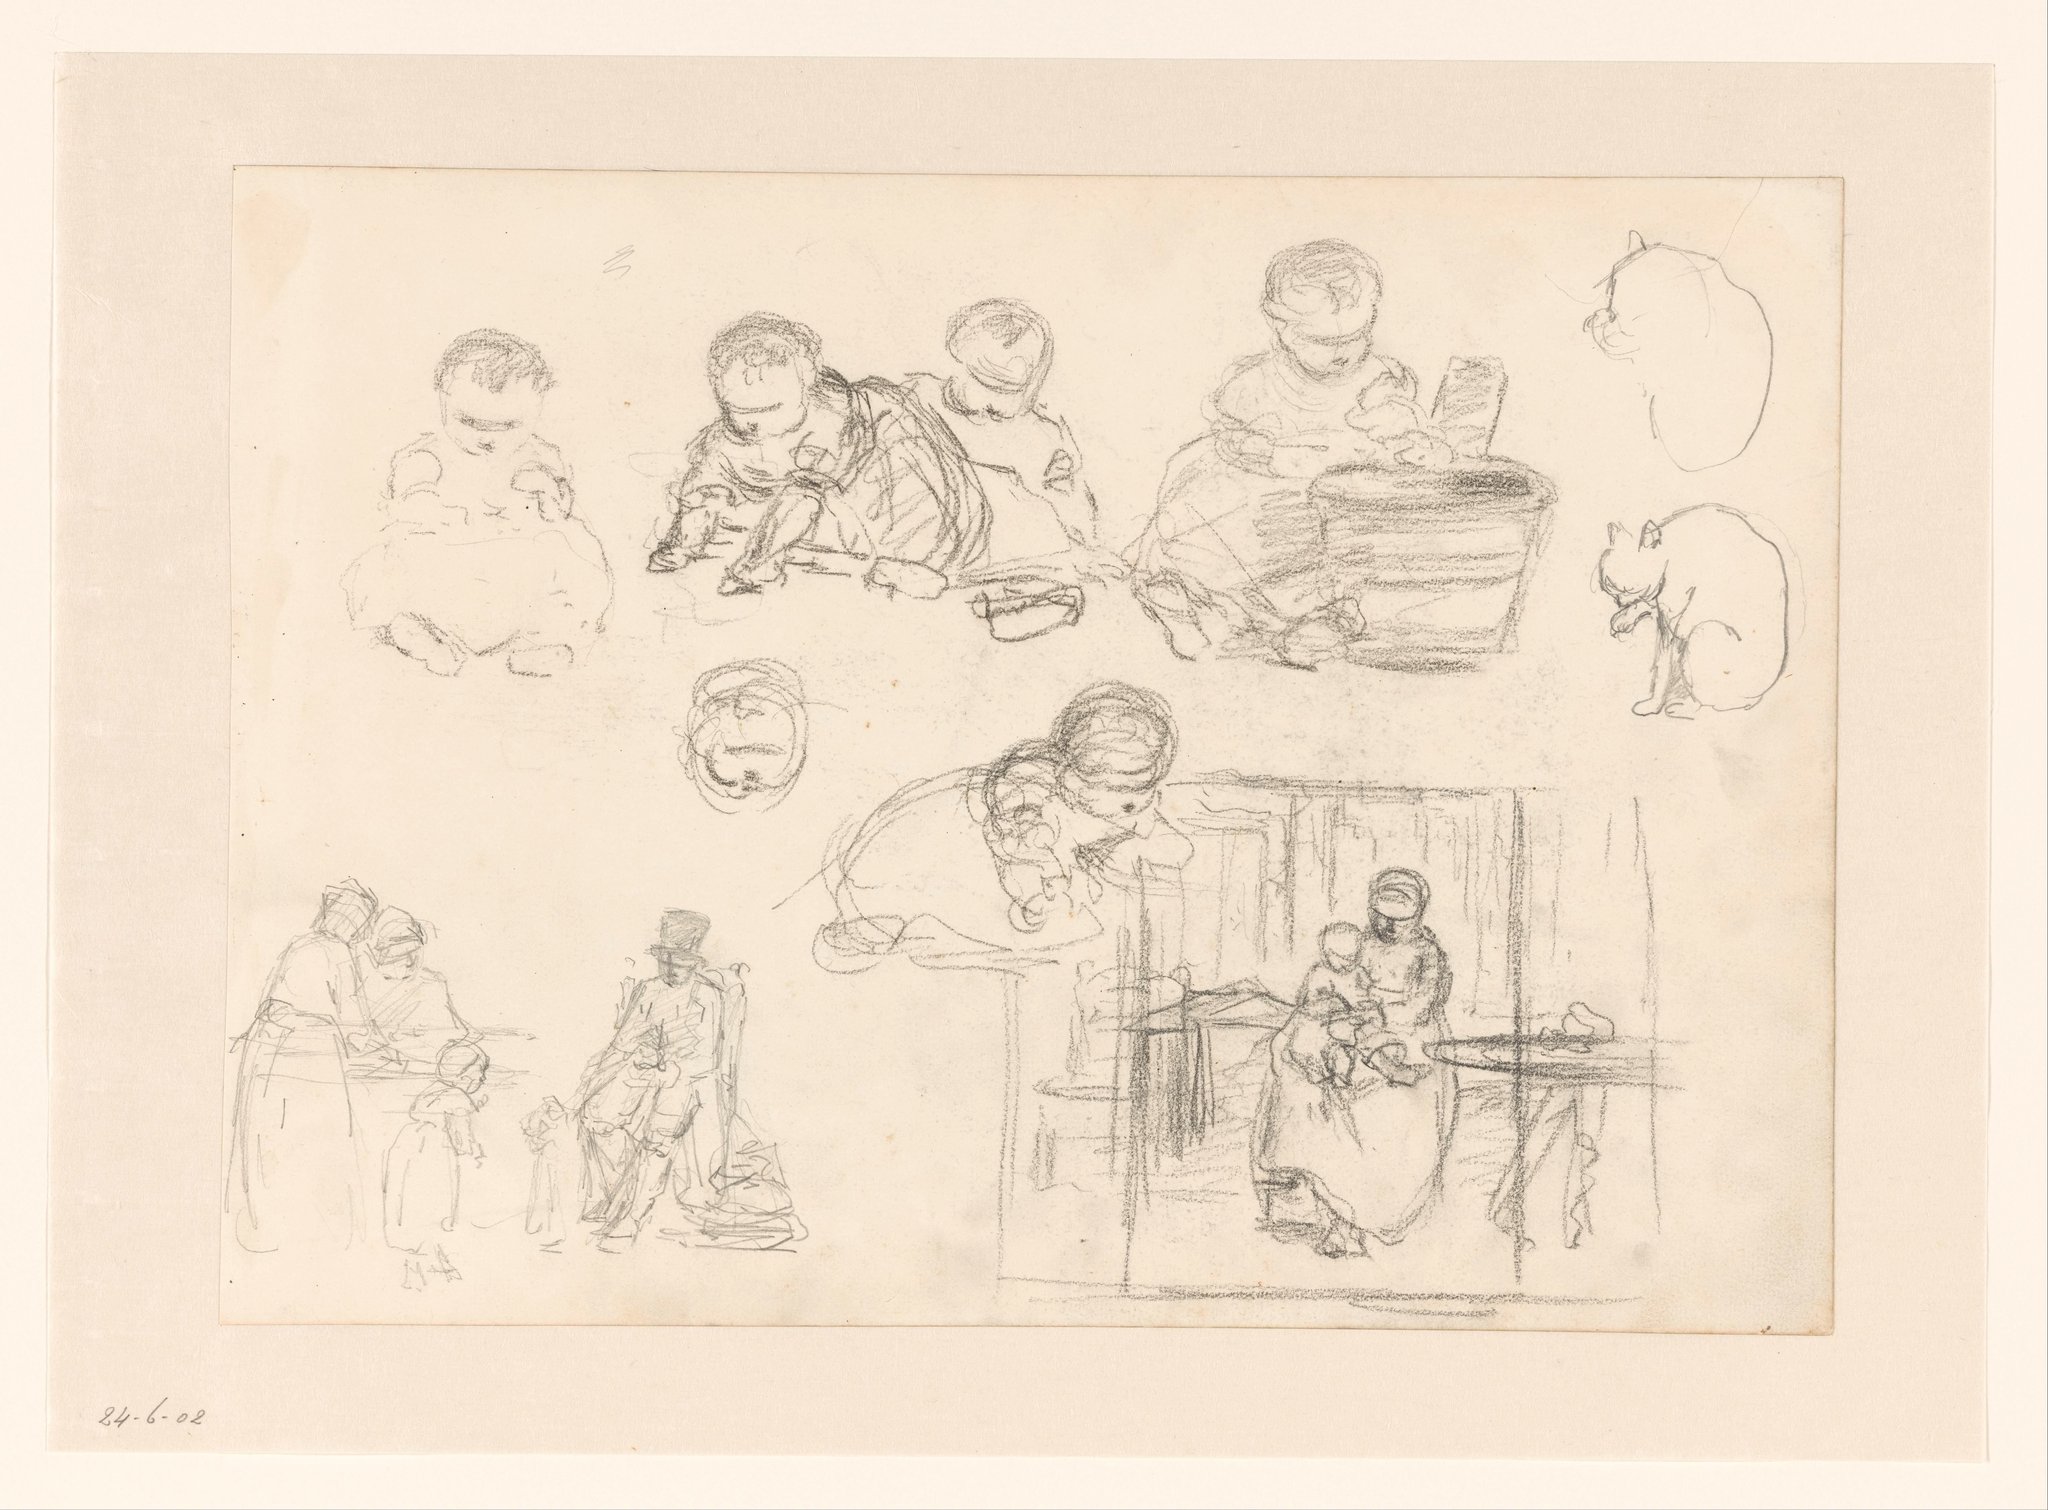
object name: drawing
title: Schetsen van kleine kinderen, moeder met kind en een kat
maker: hendrik valkenburg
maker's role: draughtsman, painter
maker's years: 1826-1896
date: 1836-1896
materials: chalk, paper, pencil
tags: interior of the house, tot, toddler ~ the ages of man